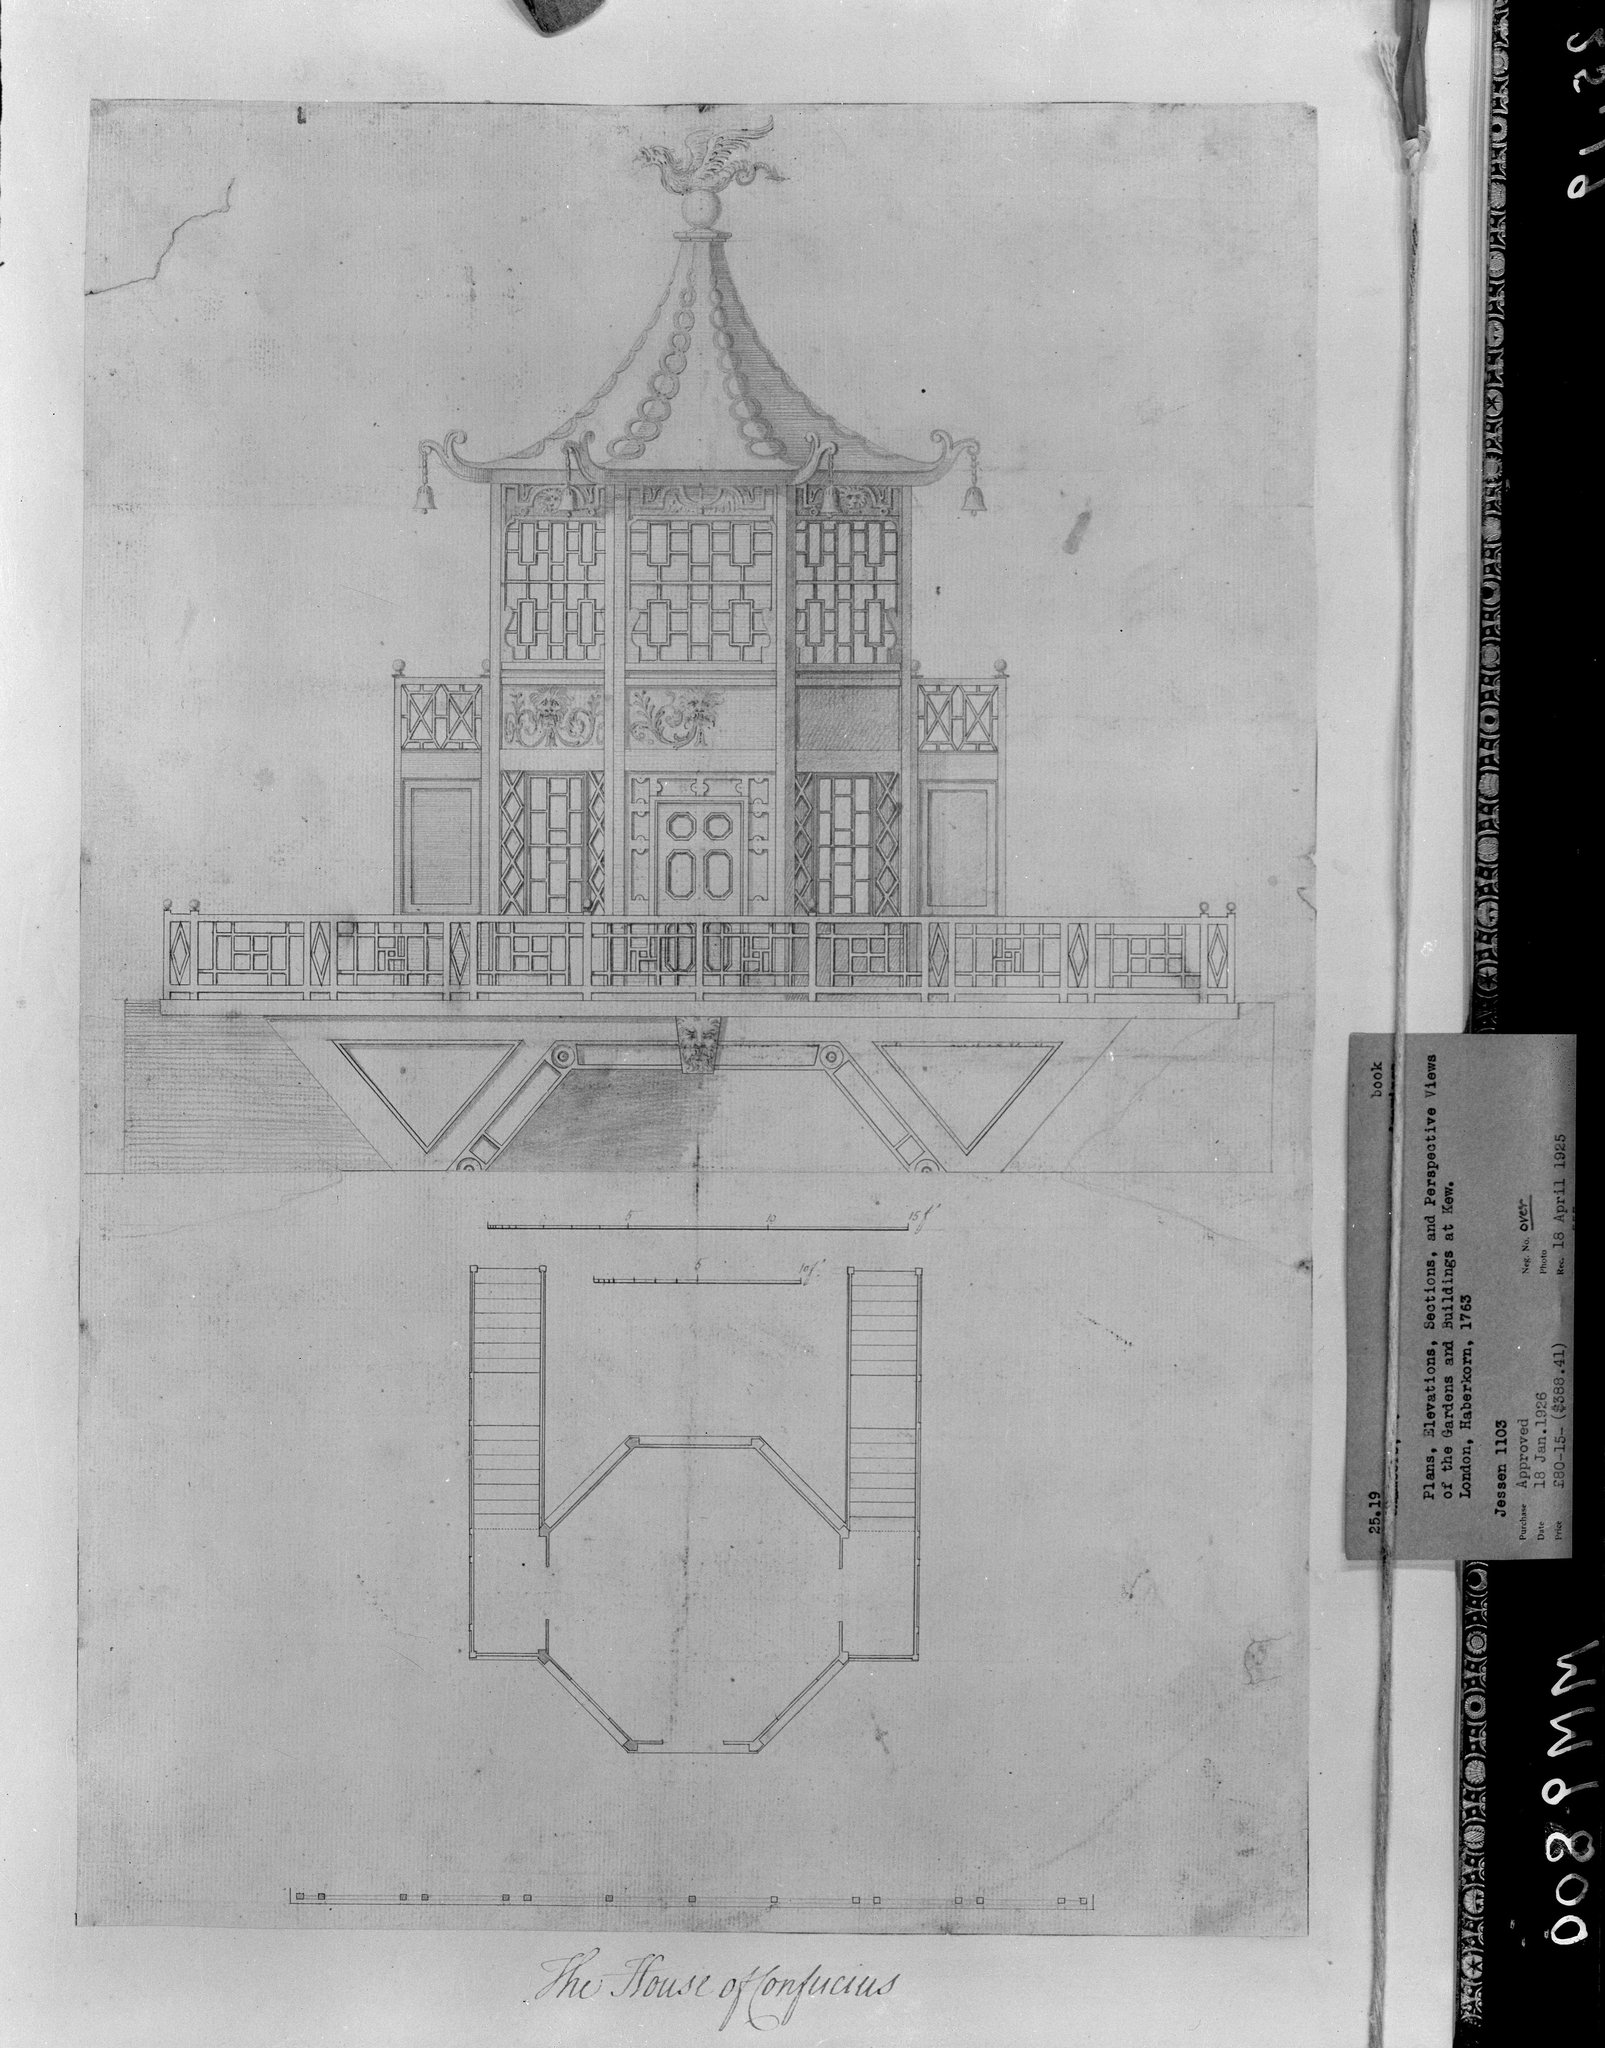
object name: book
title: Chinese Architecture, Civil and Ornamental [bound with: Chinese Architecture, Part the Second]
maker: p. decker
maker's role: artist and publisher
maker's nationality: british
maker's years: 1730-1780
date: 1759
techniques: engraving, etching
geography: england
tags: architecture